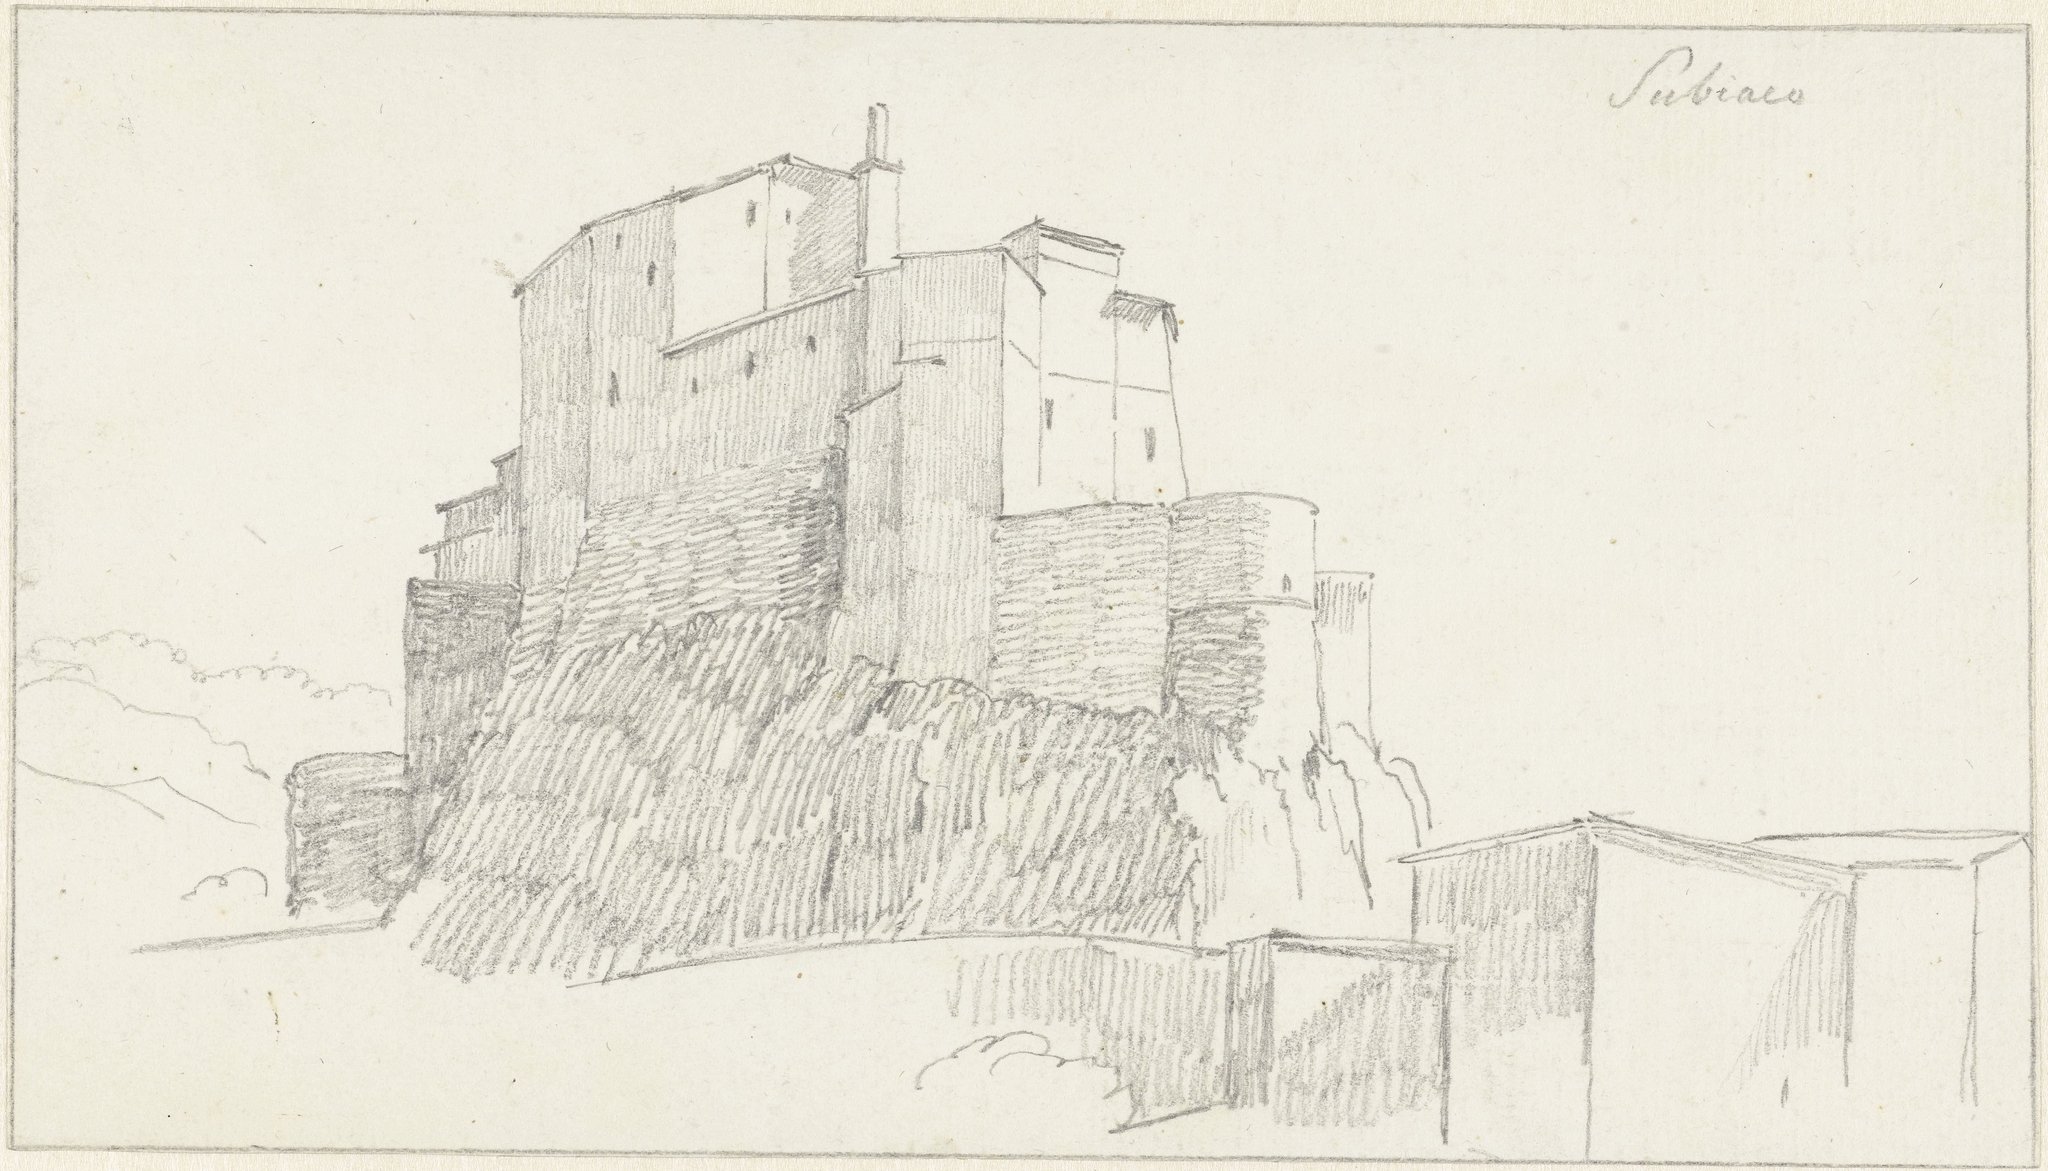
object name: drawing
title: Gezicht op het dorp Subiaco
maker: hendrik voogd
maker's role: draughtsman, painter, print maker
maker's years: 1768-1839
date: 1788-1839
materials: paper, pencil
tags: village